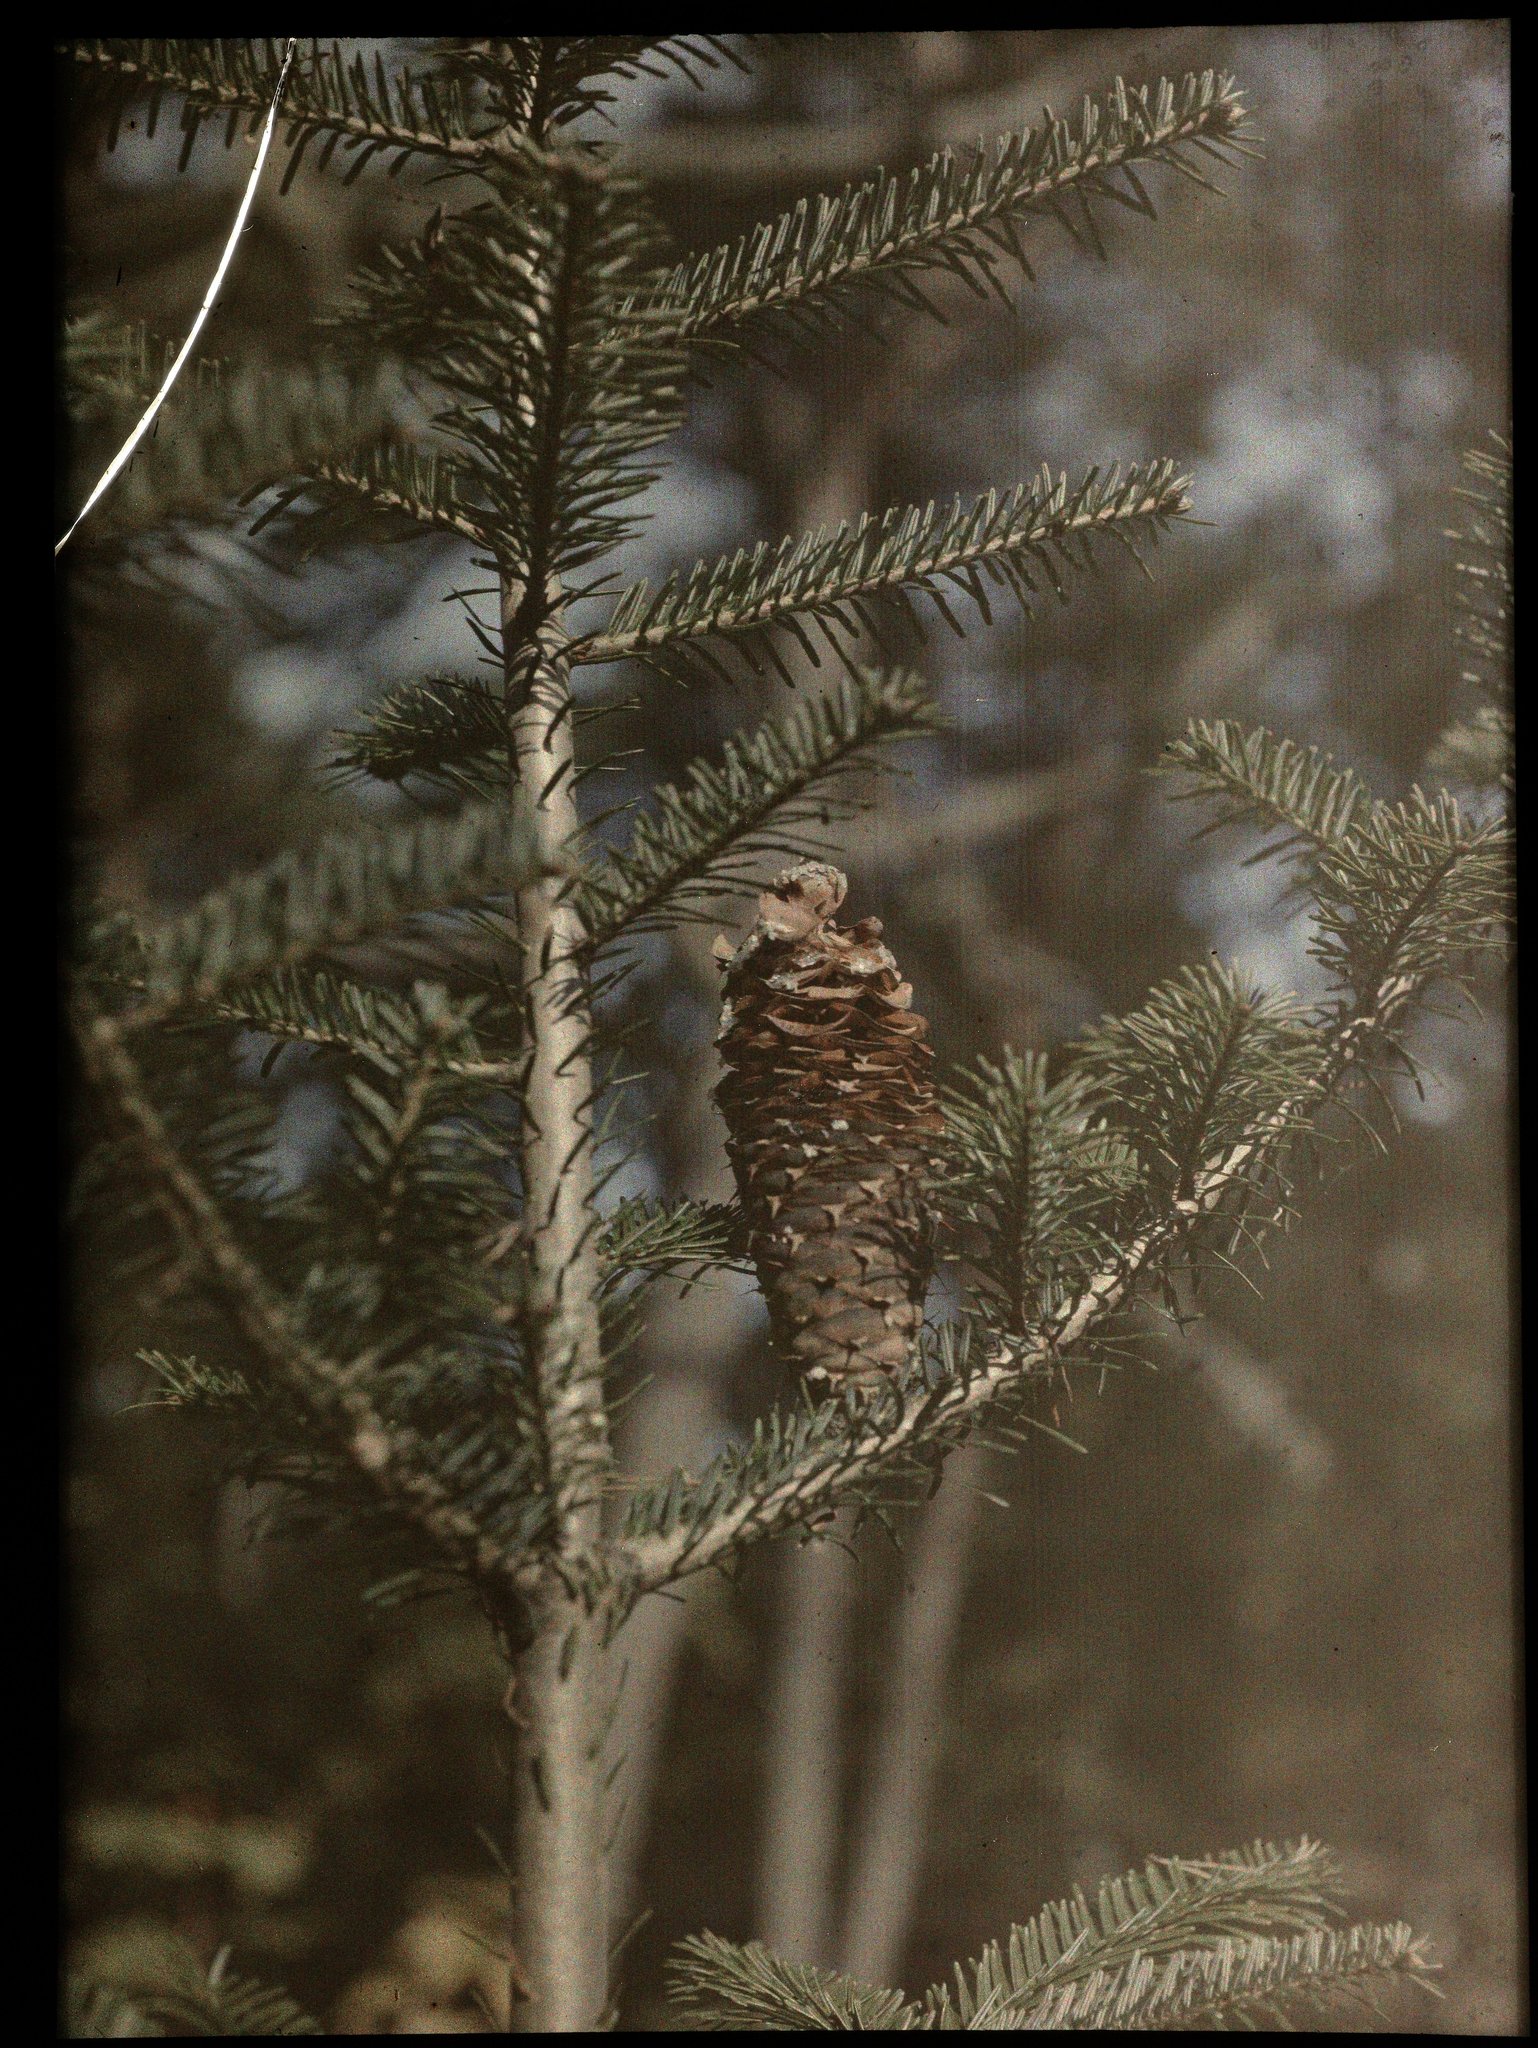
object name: color slide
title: Takken van een naaldboom, met een dennenappel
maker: adolphe burdet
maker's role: fotograaf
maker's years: 1860-1940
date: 1907-1930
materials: glass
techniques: autochrome process, slide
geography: netherlands